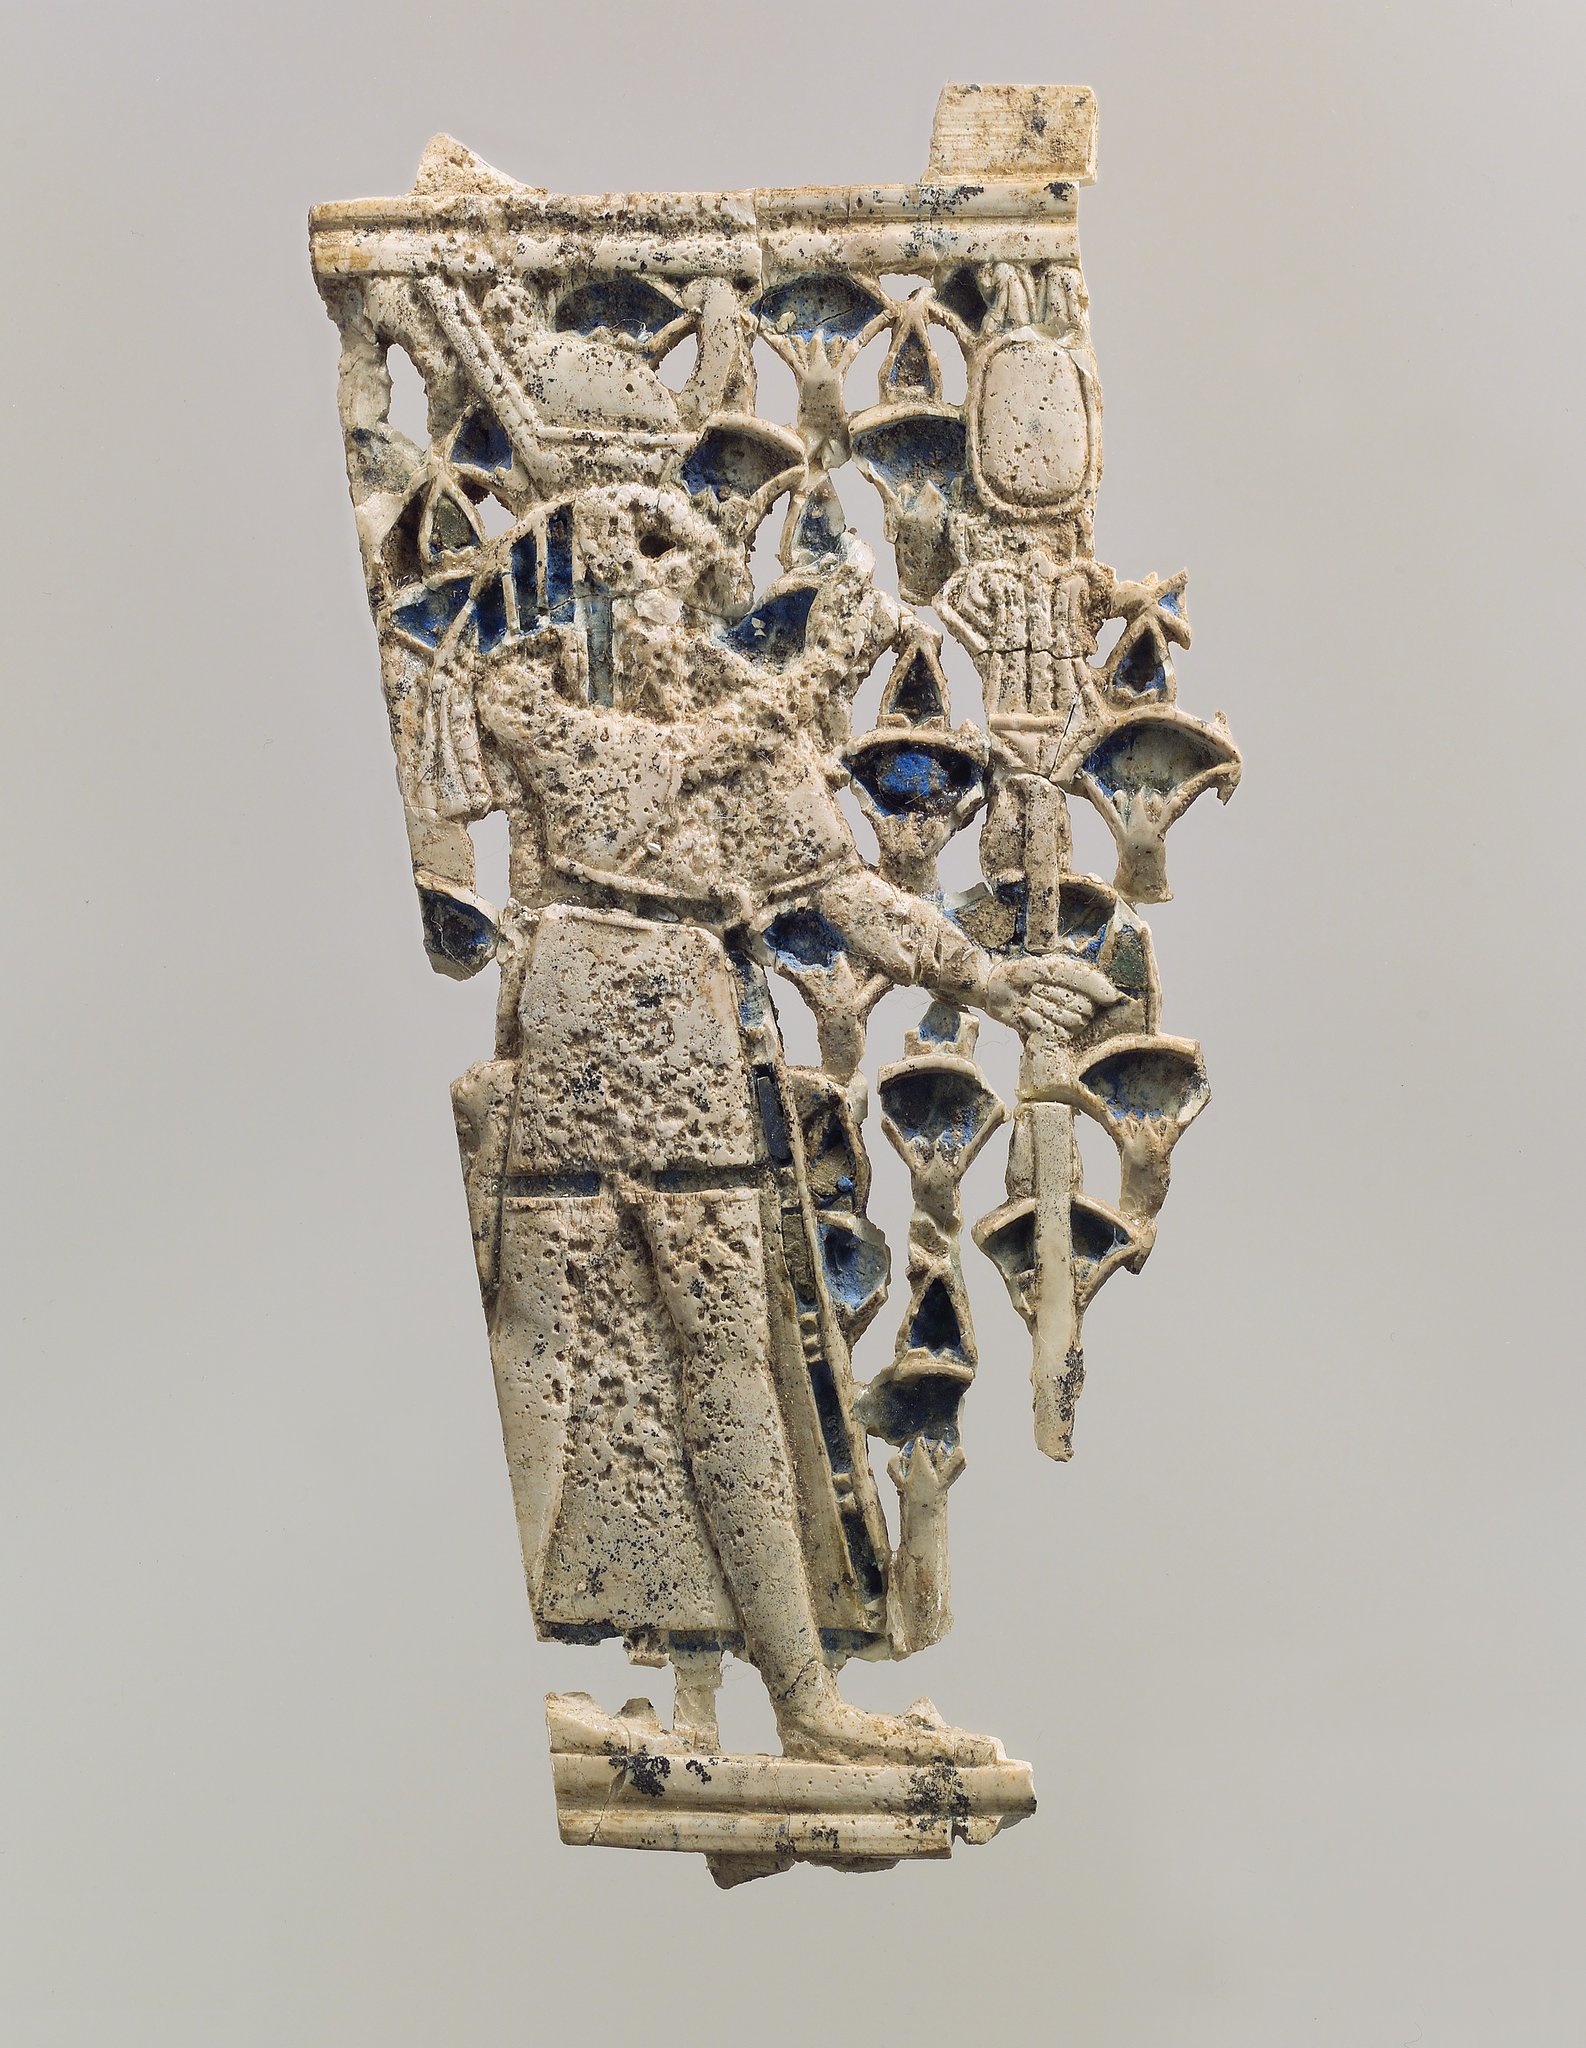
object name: relief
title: Openwork furniture plaque with a falcon-headed figure in a papyrus thicket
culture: assyrian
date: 900-701 BCE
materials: ivory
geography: mesopotamia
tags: falcons,horus